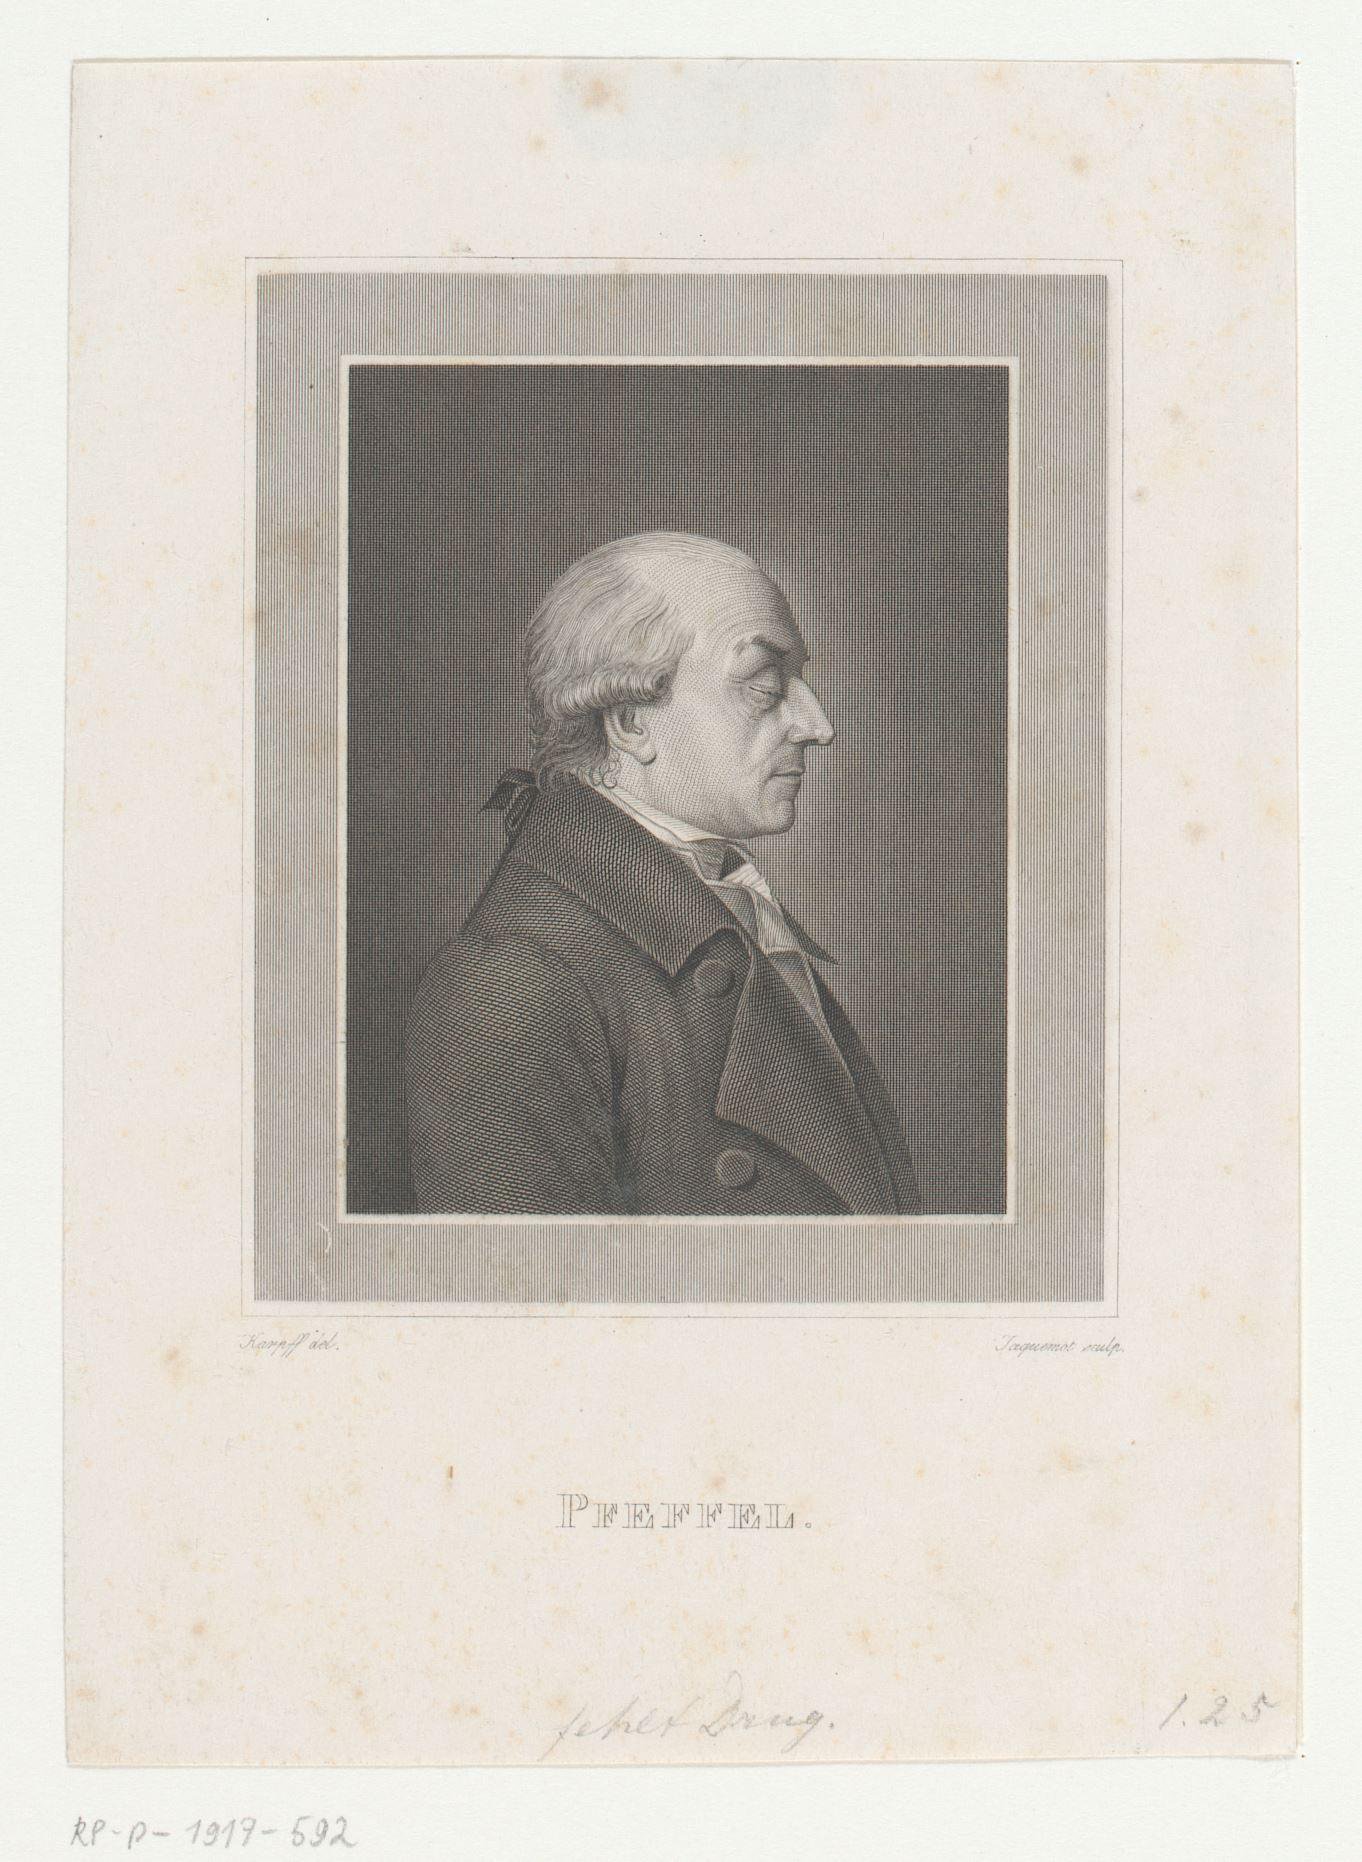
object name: print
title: Pfeffel.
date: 1816-1880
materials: paper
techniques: engraving, etching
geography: france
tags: historical persons, portrait of a writer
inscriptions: collector's mark: Lugt 2228